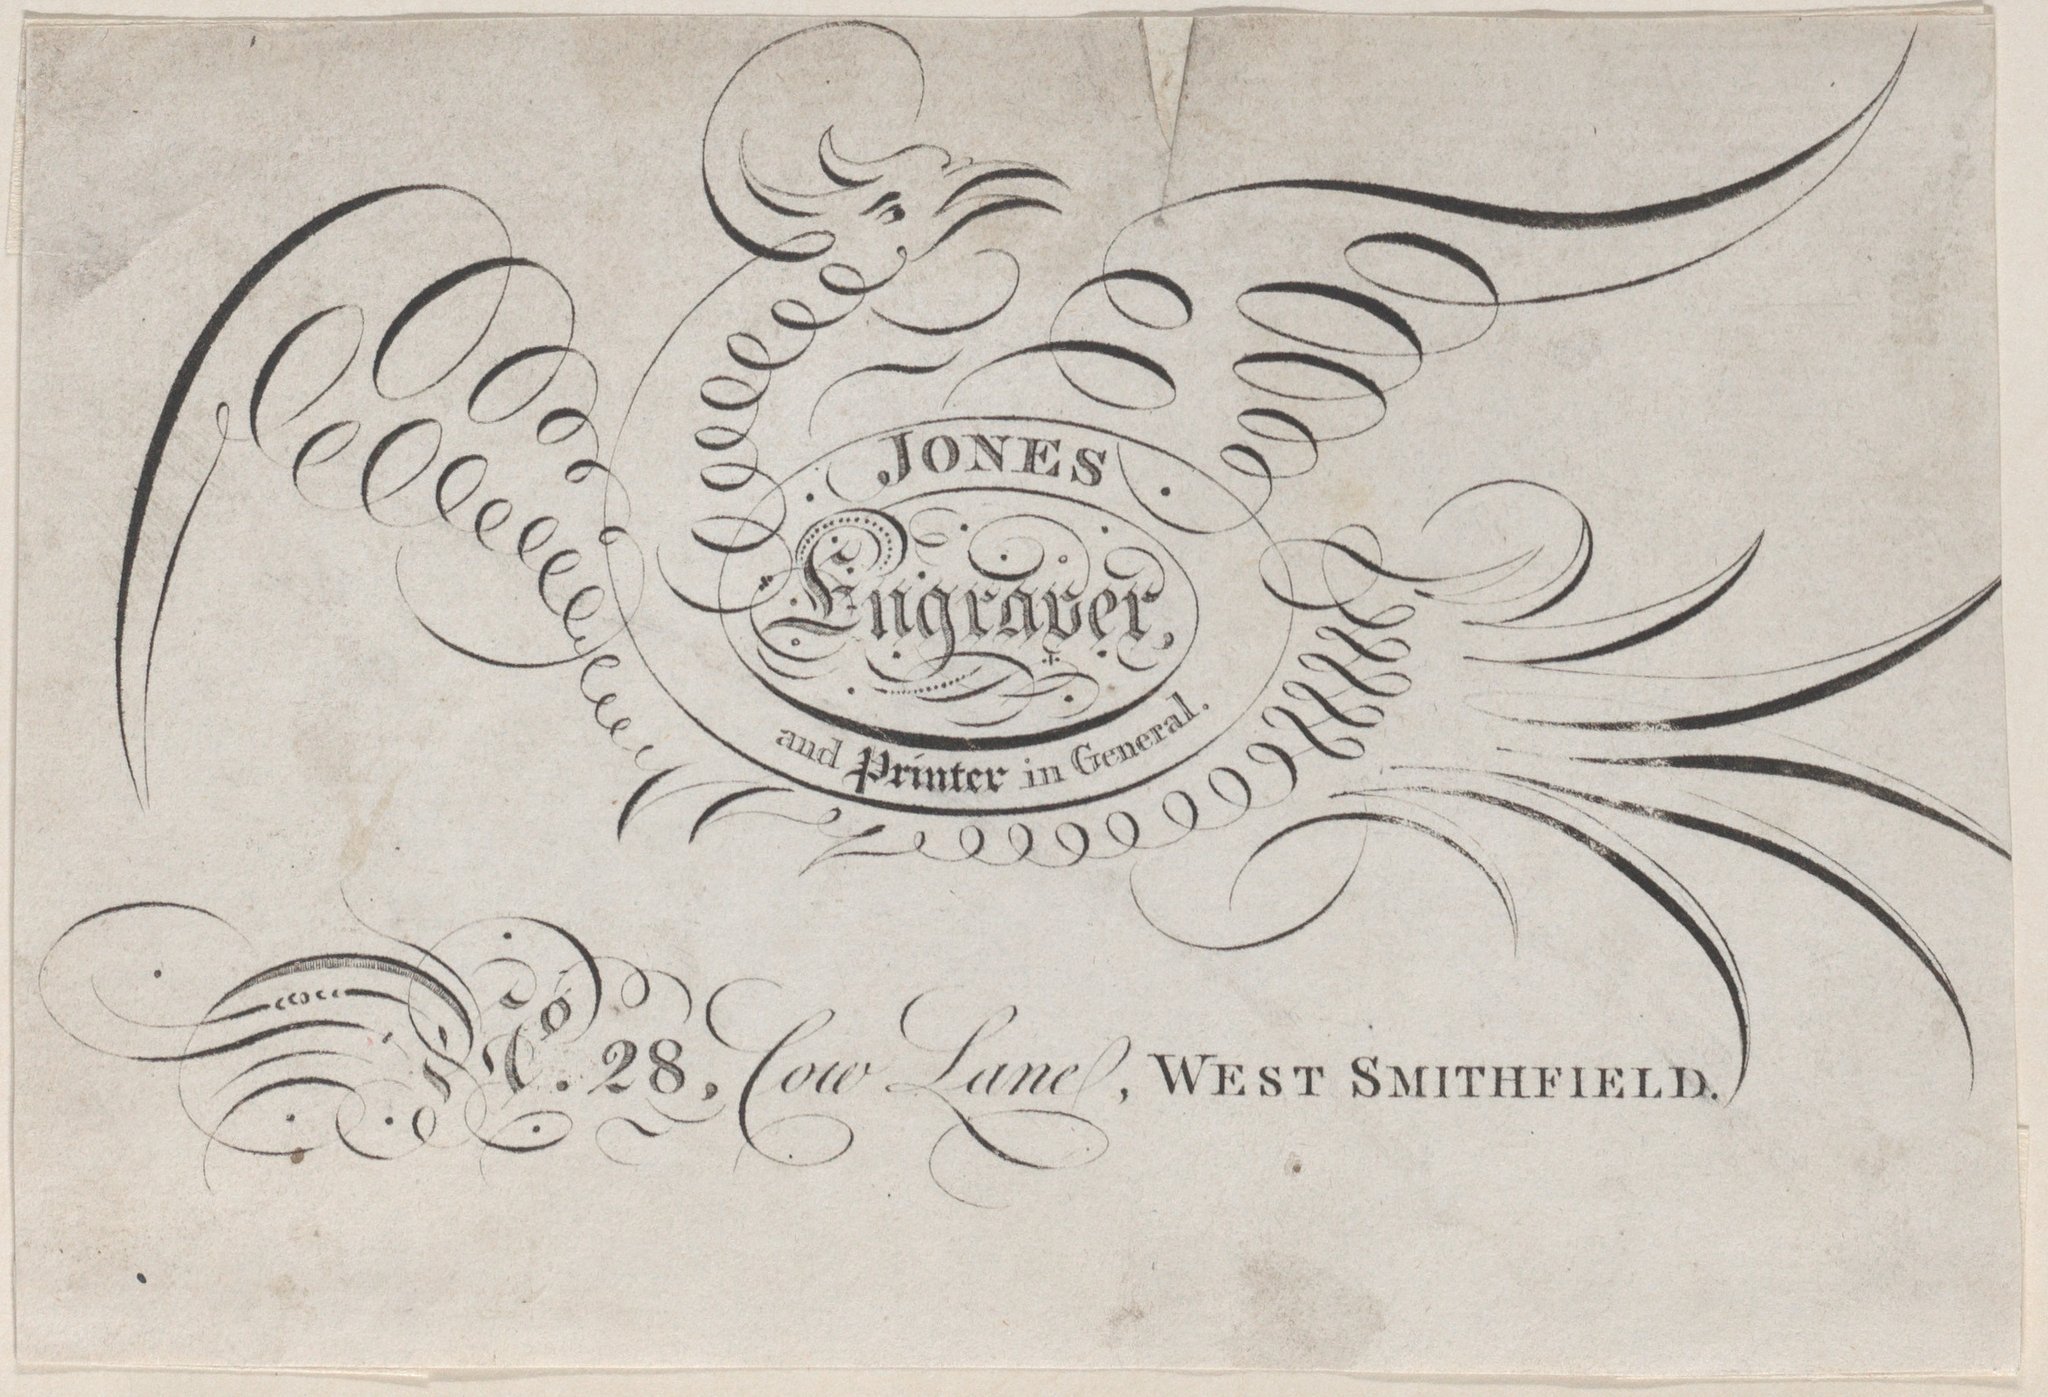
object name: print, trade card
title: Trade Card for Jones, Engraver and Printer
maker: anonymous, british, 19th century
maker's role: artist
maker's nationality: british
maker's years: 1800-1900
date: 1801-1900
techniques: engraving